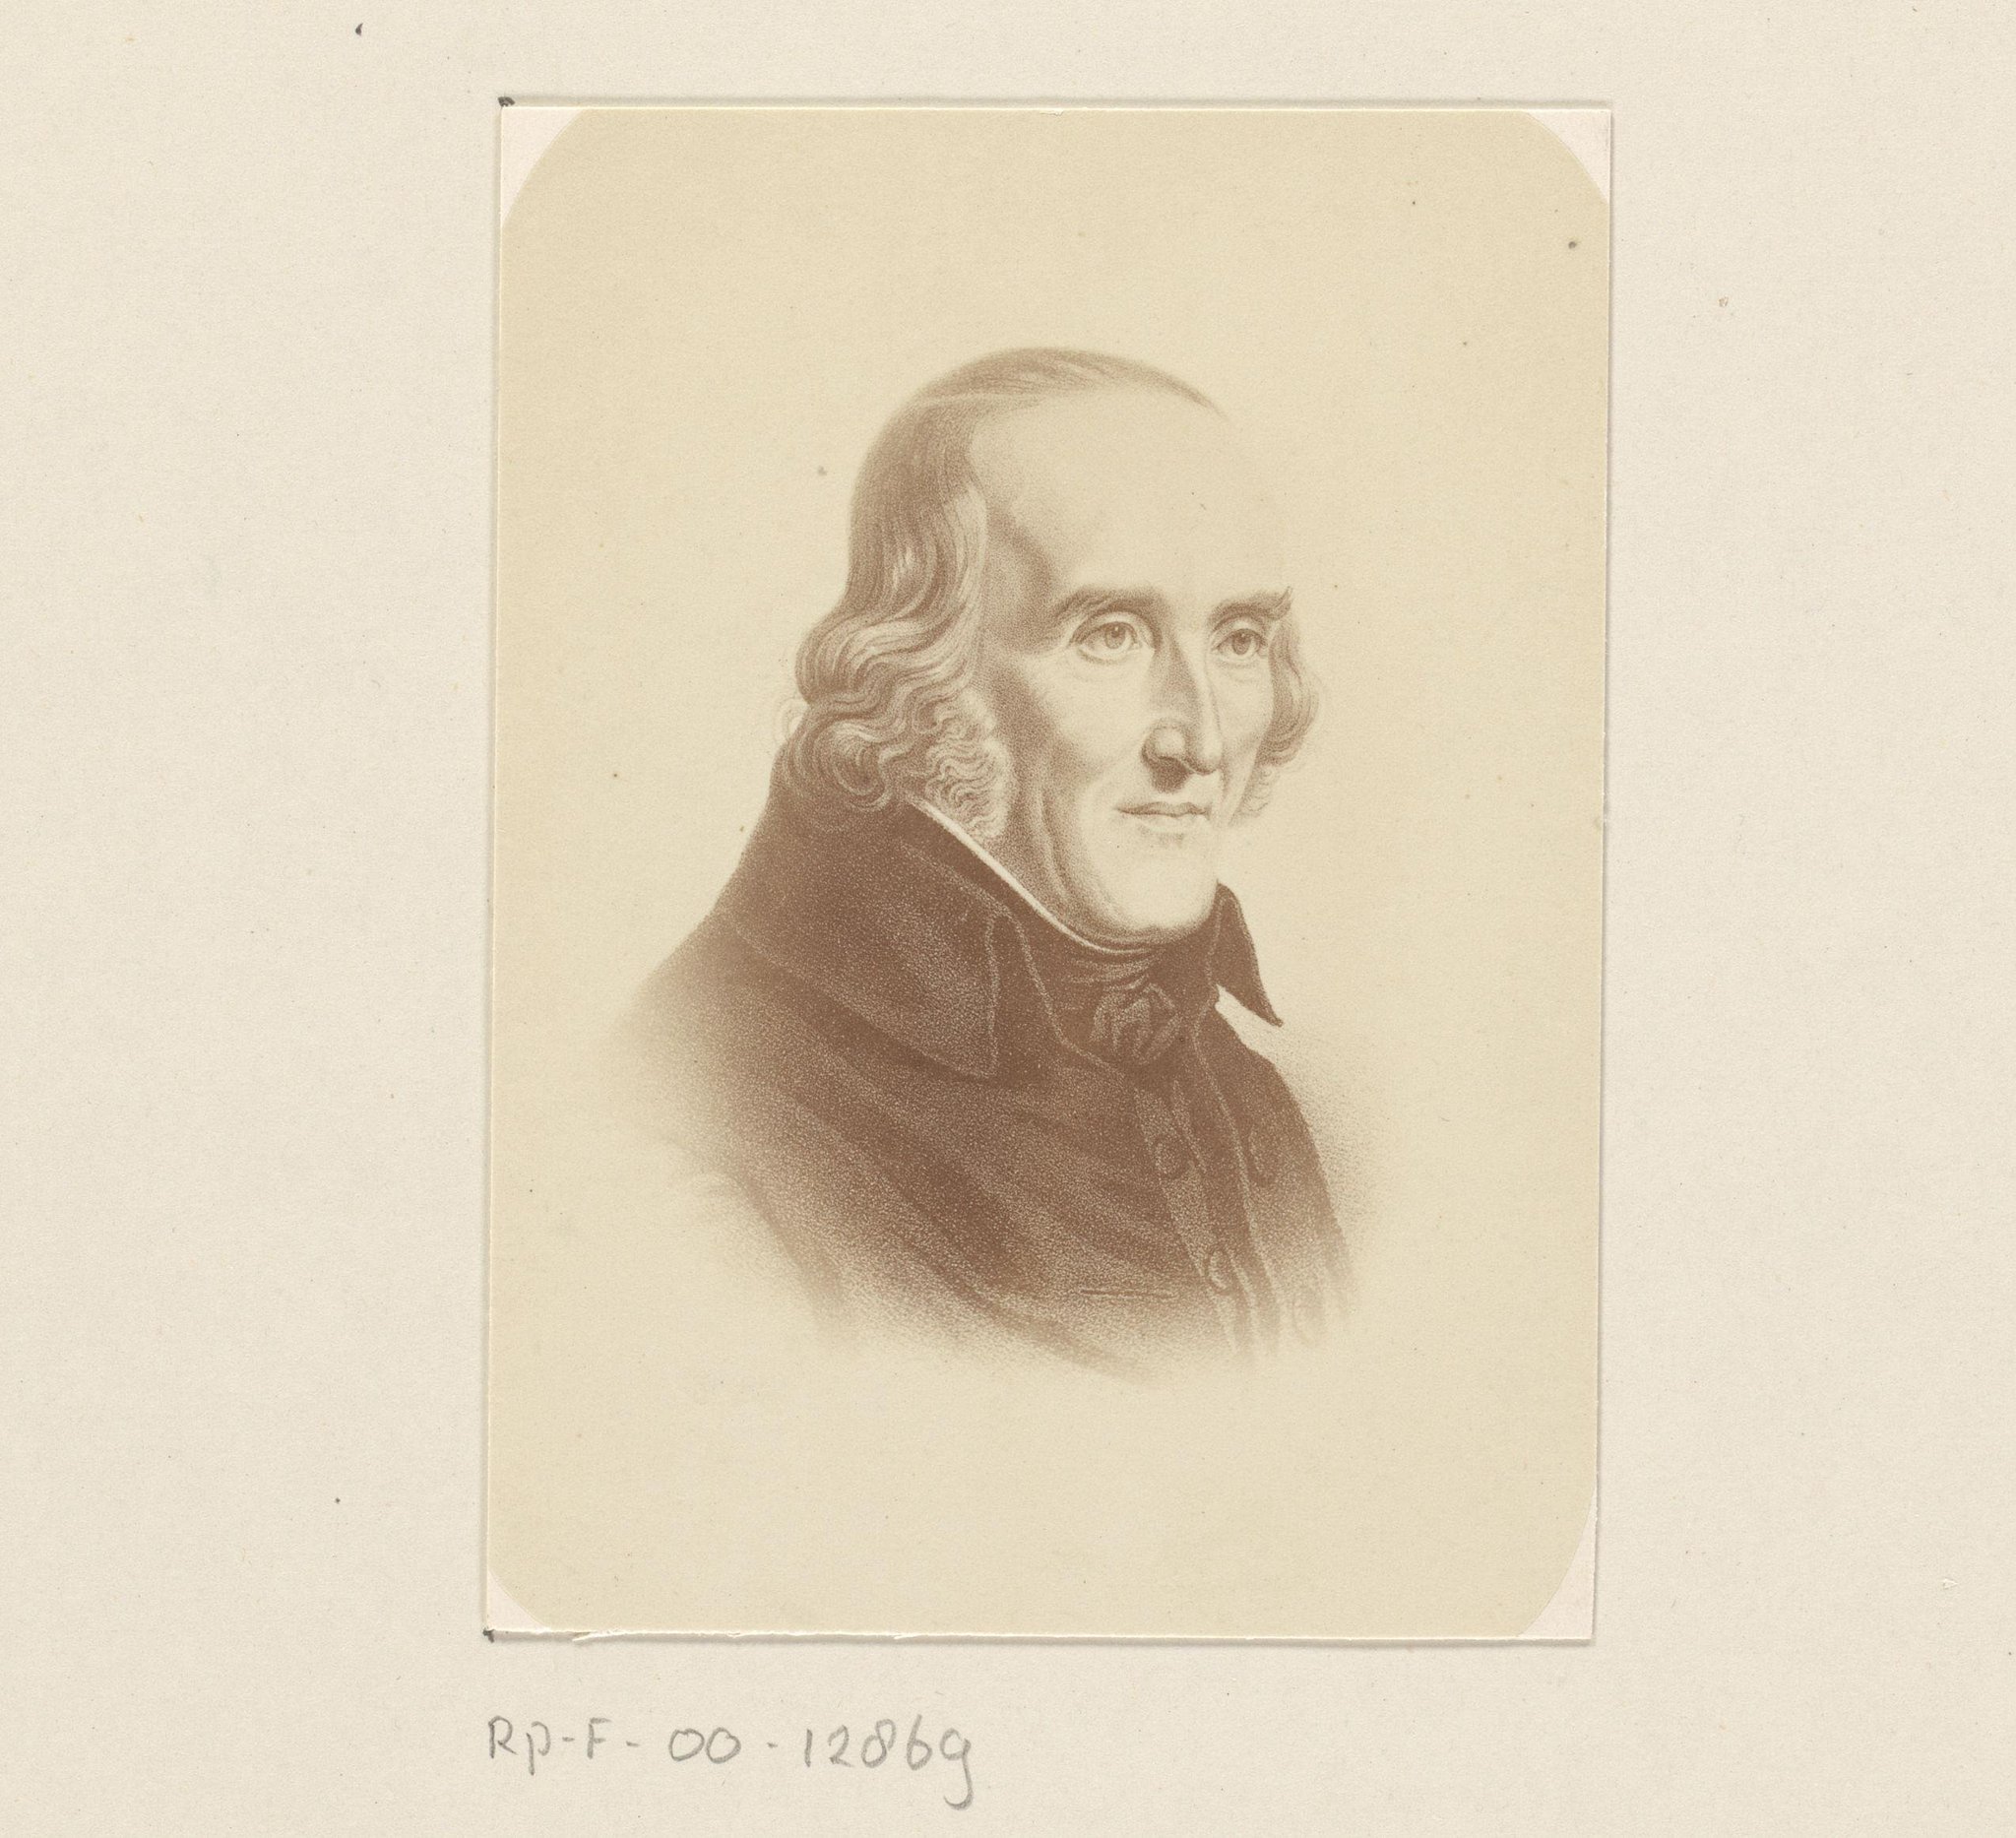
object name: photograph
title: Fotoreproductie van een prent van Johann Baptist von Hirscher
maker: Anonymous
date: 1851-1900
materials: cardboard, paper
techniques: albumen print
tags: johann baptist von hirscher, print, e.g.: engraving, etching, lithograph, historical persons